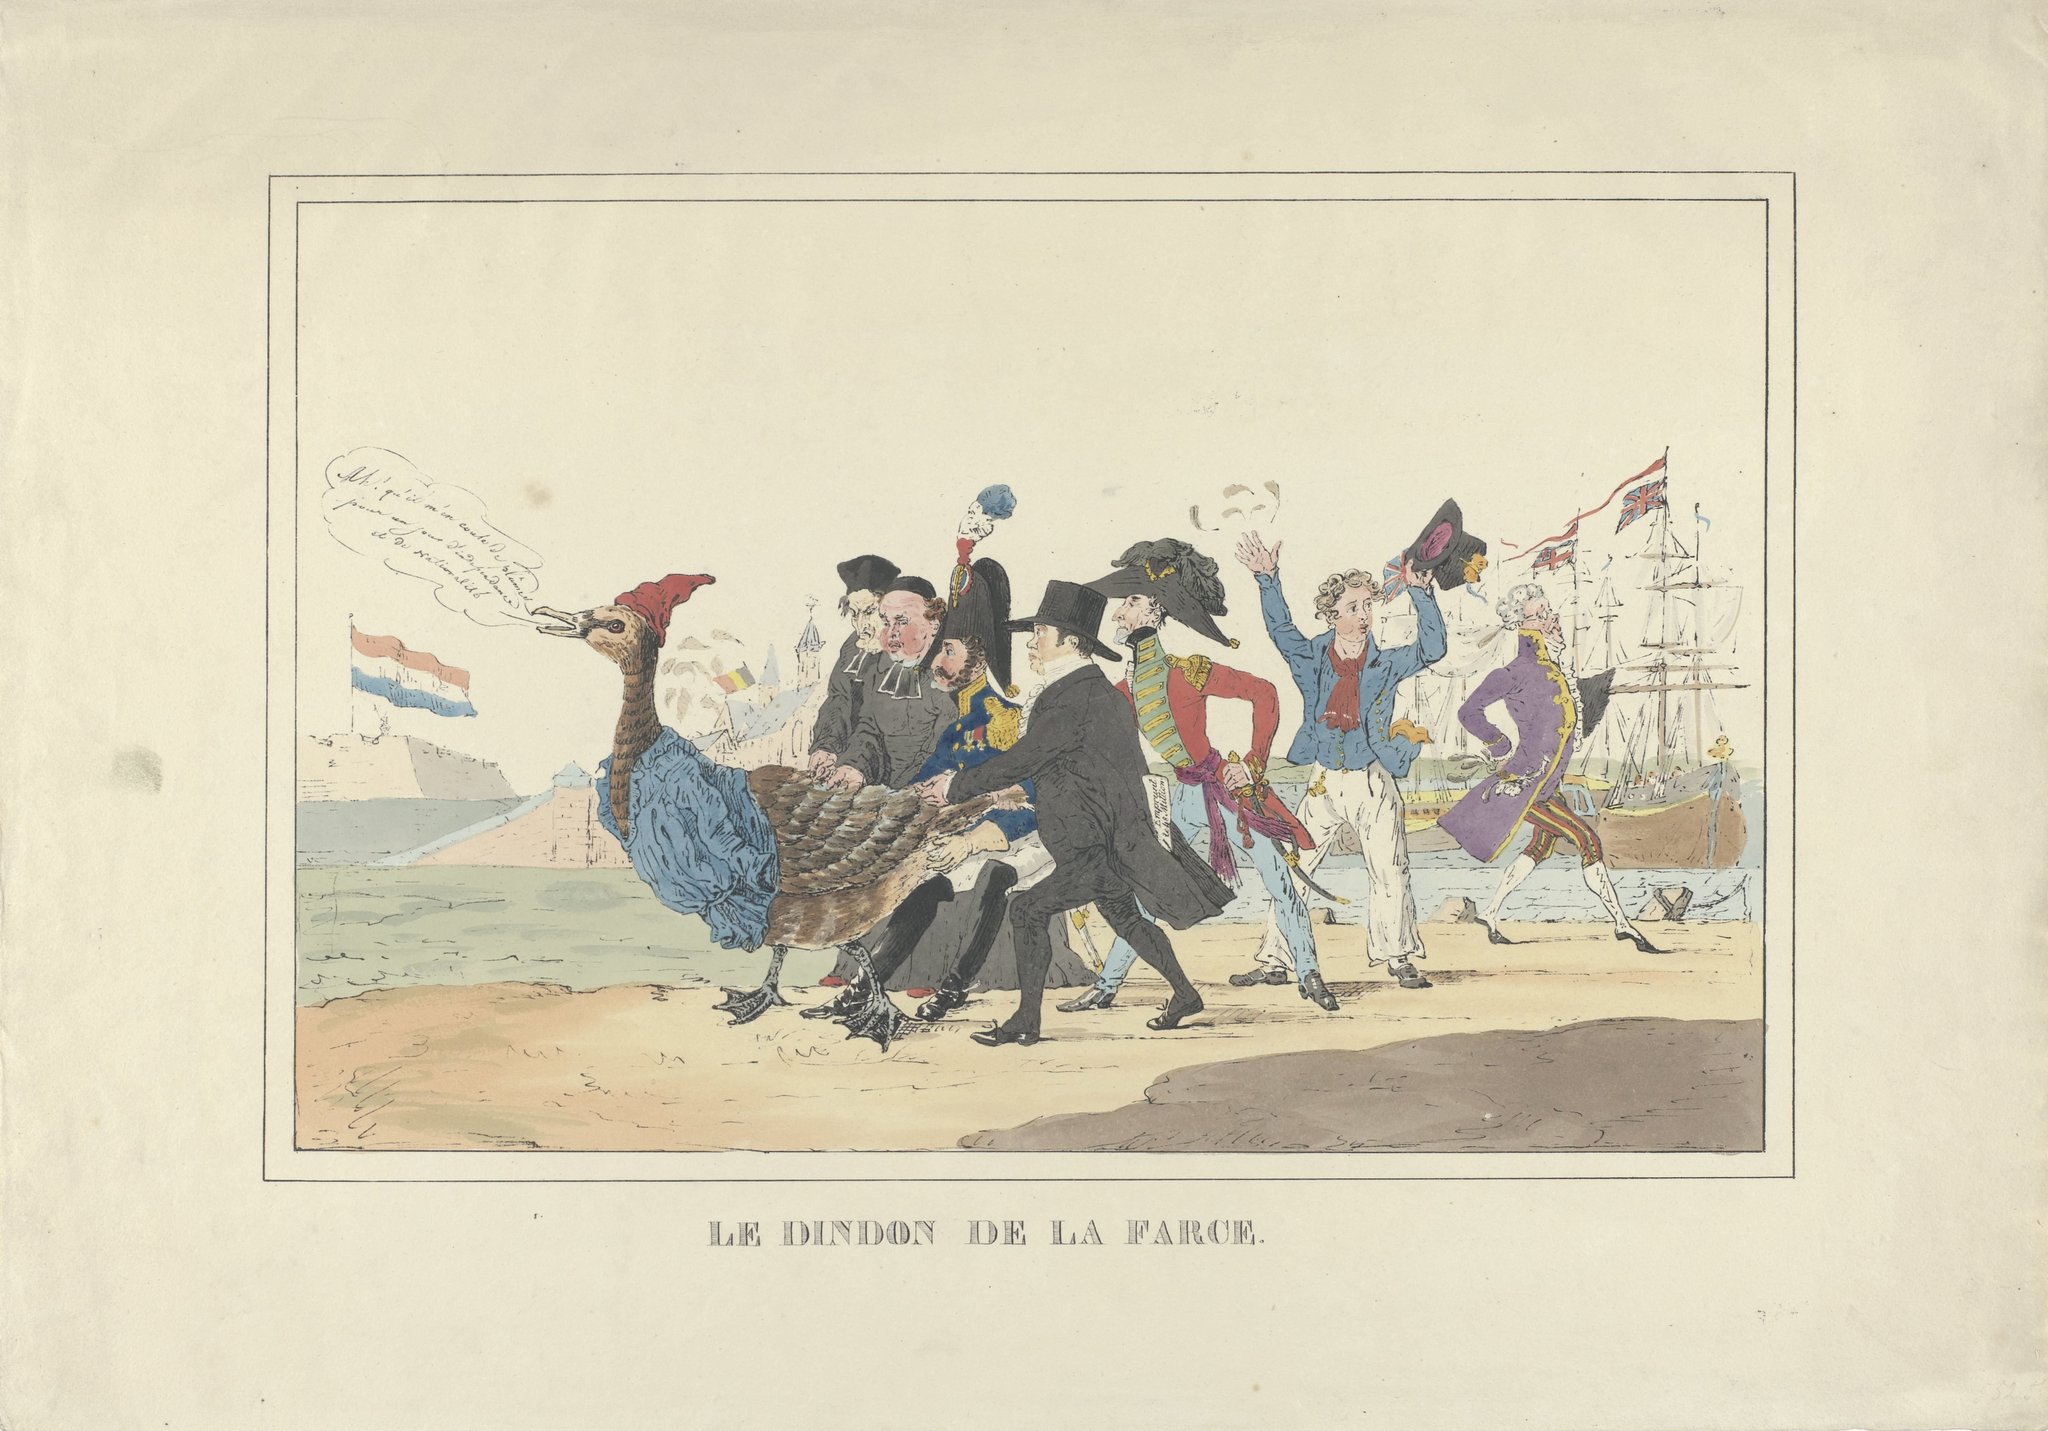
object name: print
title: België uitgebuit door verschillende landen, 1831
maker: paulus charles gerard poelman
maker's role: draughtsman, painter, print maker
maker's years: 1792-1846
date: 1831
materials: paper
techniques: hand coloring, lithograph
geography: netherlands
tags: politician, water-birds: goose, cleaning fowl or small animals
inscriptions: collector's mark: Lugt 2228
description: Spotprent met het vrije België voorgesteld als een gans in een blauwe werkmanskiel en met jacobijnenmuts, 1831. Twee geestelijken, een Frans en een Engels officier en een financier (Rothschild?) trachten allen tegelijkertijd de gans te plukken. Een Hollandse matroos heeft al eerder het plukken opgegeven, rechts loopt Surlet de Chokier tevreden weg. Op de achtergrond wappert de Nederlandse vlag op de citadel van Antwerpen, rechts Britse schepen.